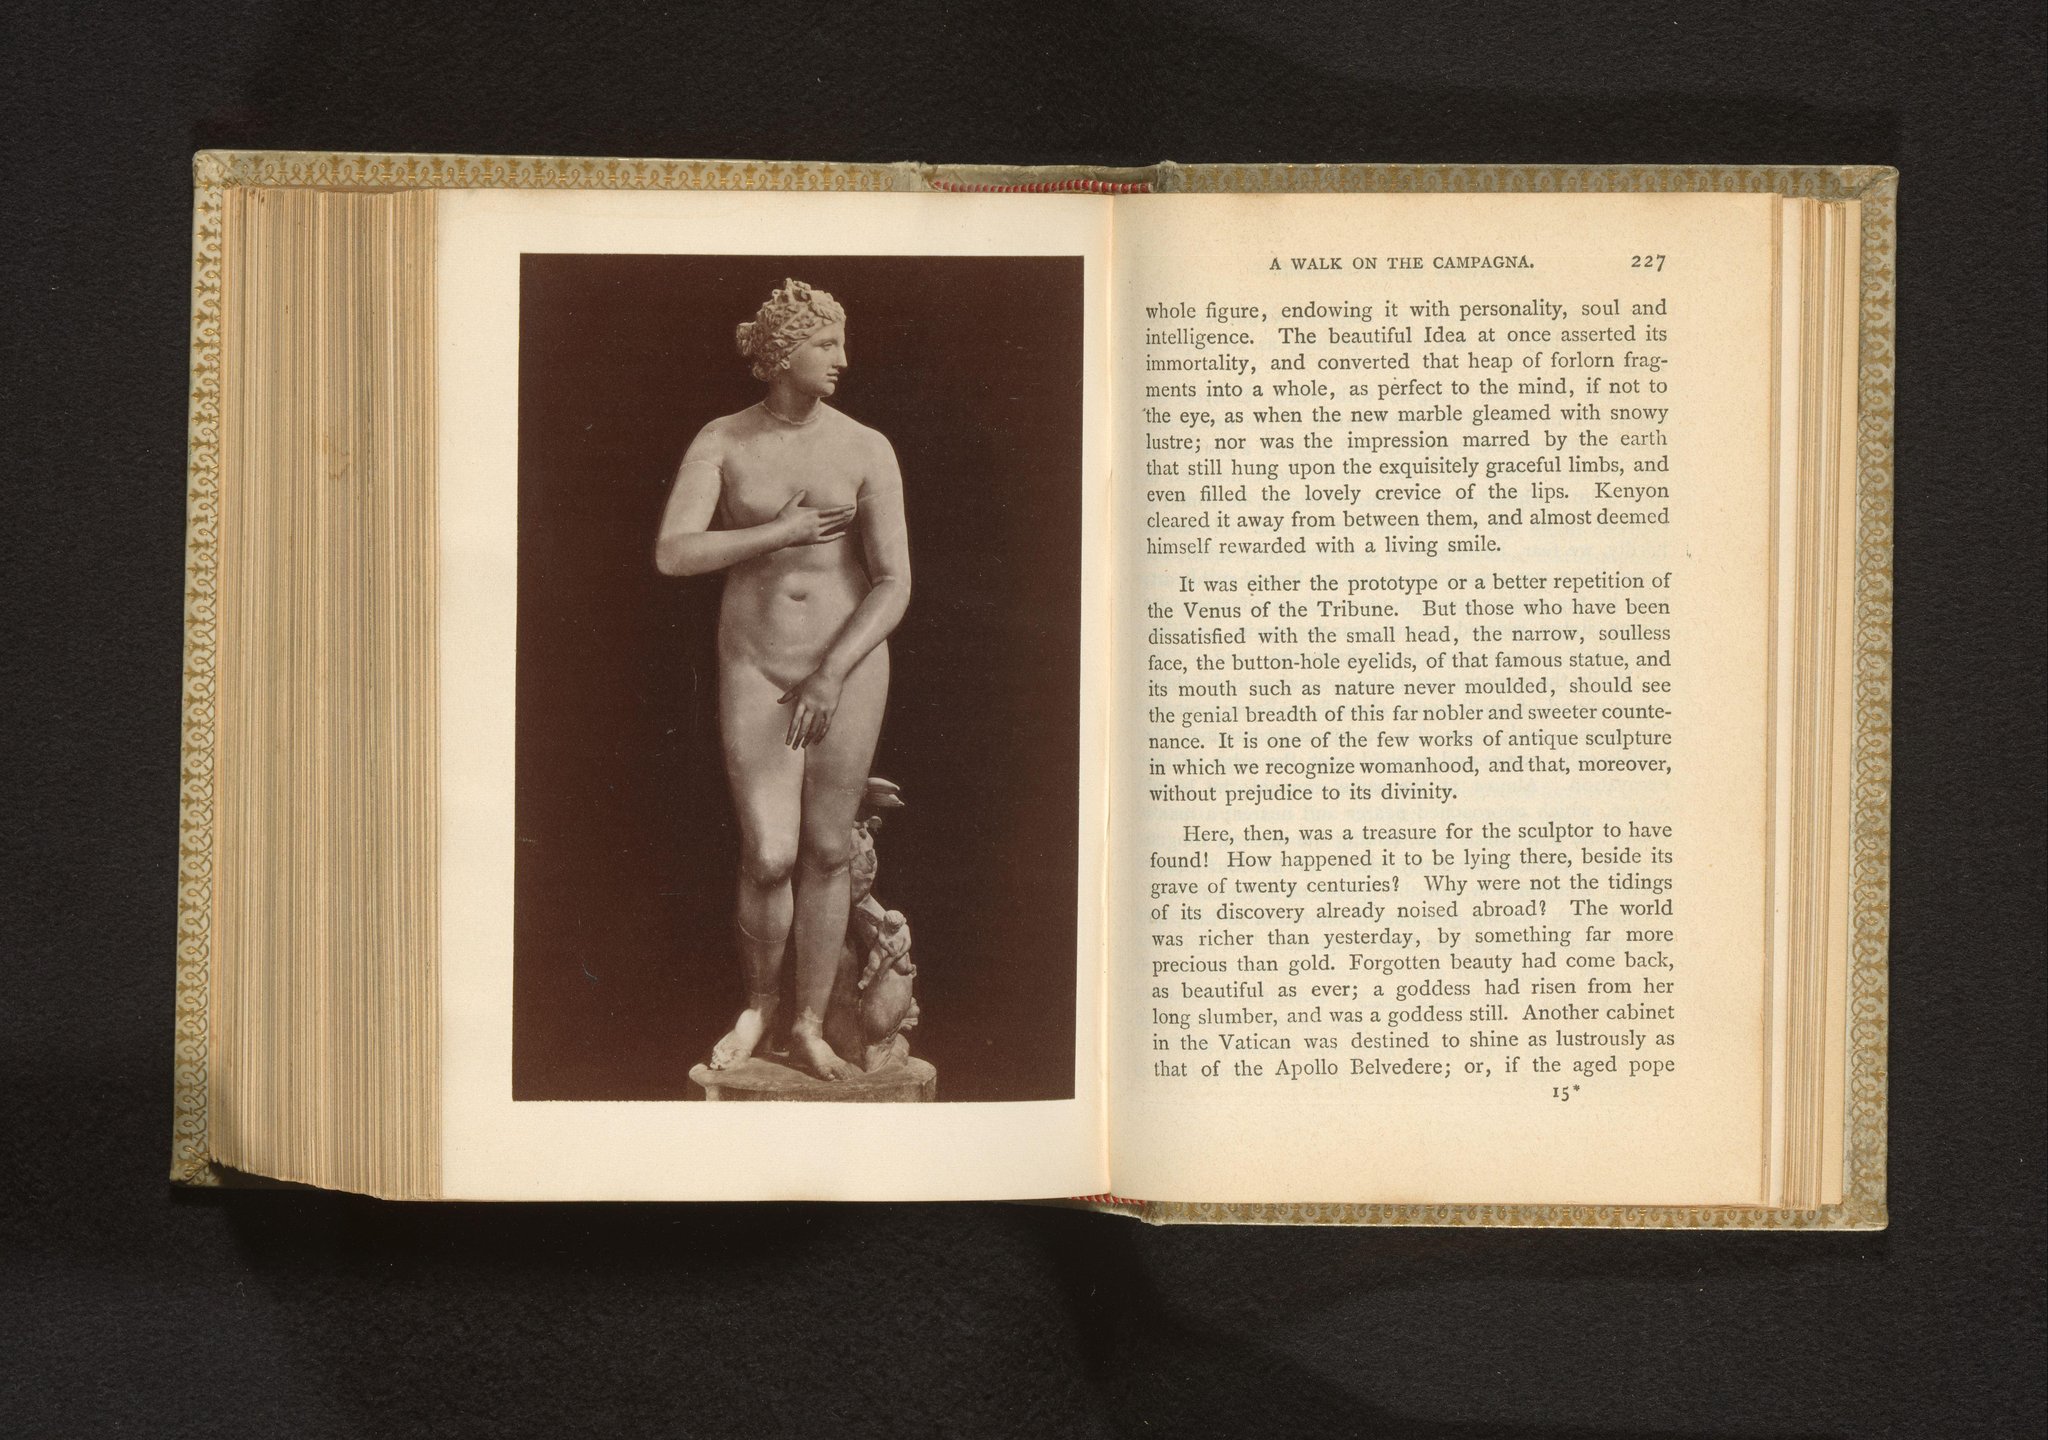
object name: page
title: Venus de' Medici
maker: Anonymous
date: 1850-1860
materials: photographic support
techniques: albumen print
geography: italy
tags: (story of) venus (aphrodite)